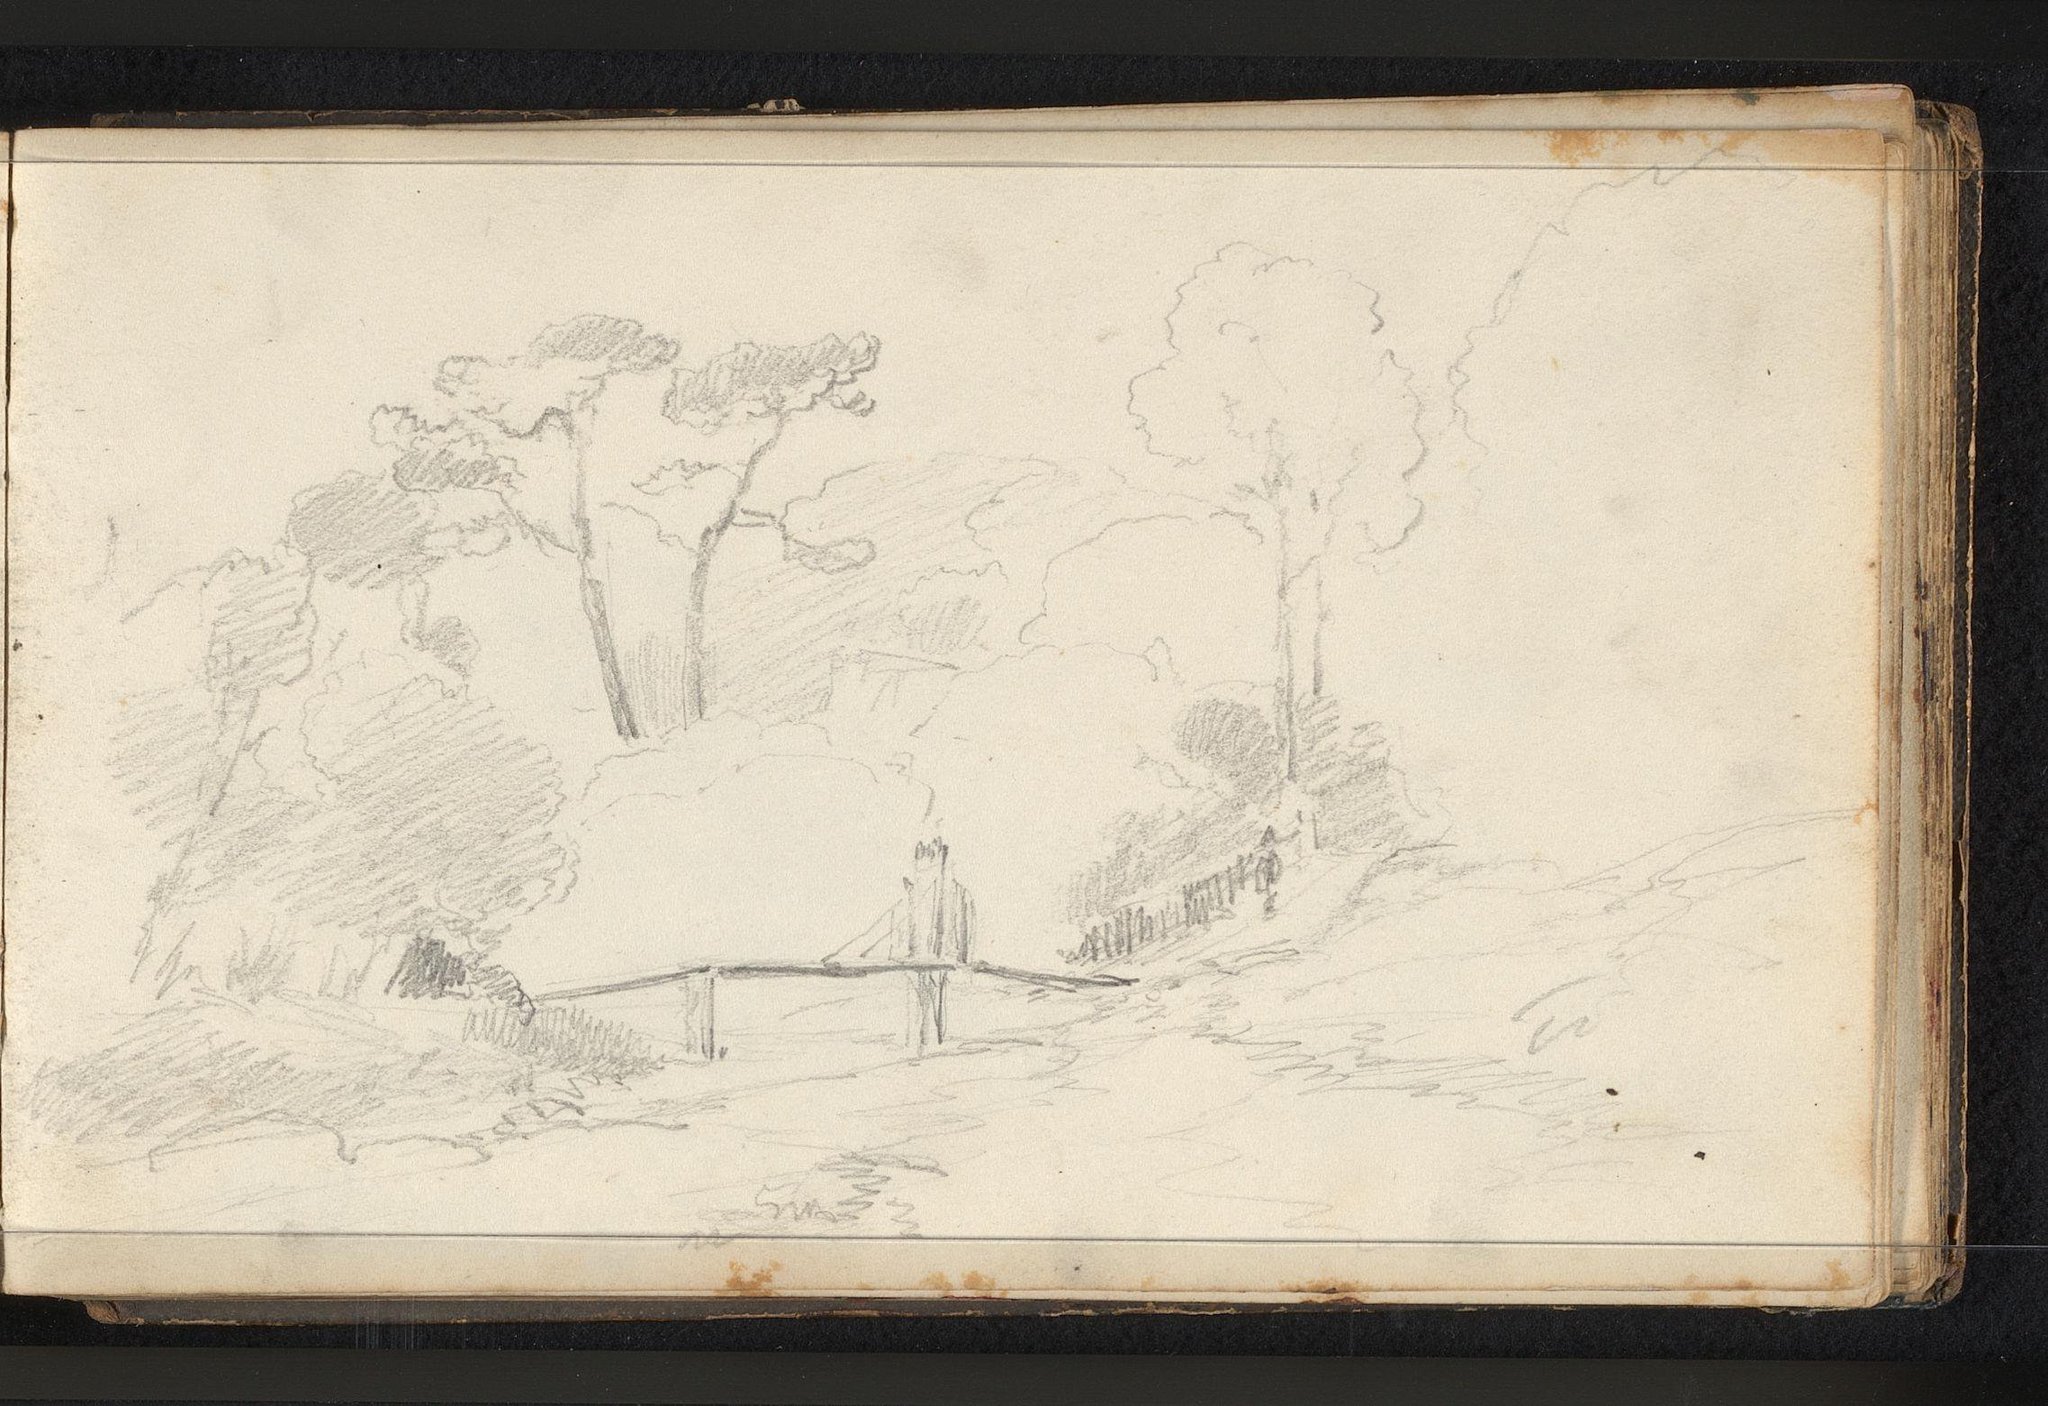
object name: sketchbook leaf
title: Landschap met begroeiing en brug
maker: jan bedijs tom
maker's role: draughtsman, painter, print maker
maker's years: 1813-1894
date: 1828-1894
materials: paper, pencil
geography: the hague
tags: plants; vegetation, landscapes, landscape with bridge, viaduct or aqueduct, artist (in general) making preliminary designs, sketching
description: Pagina 28 verso uit een schetsboek met 54 bladen.